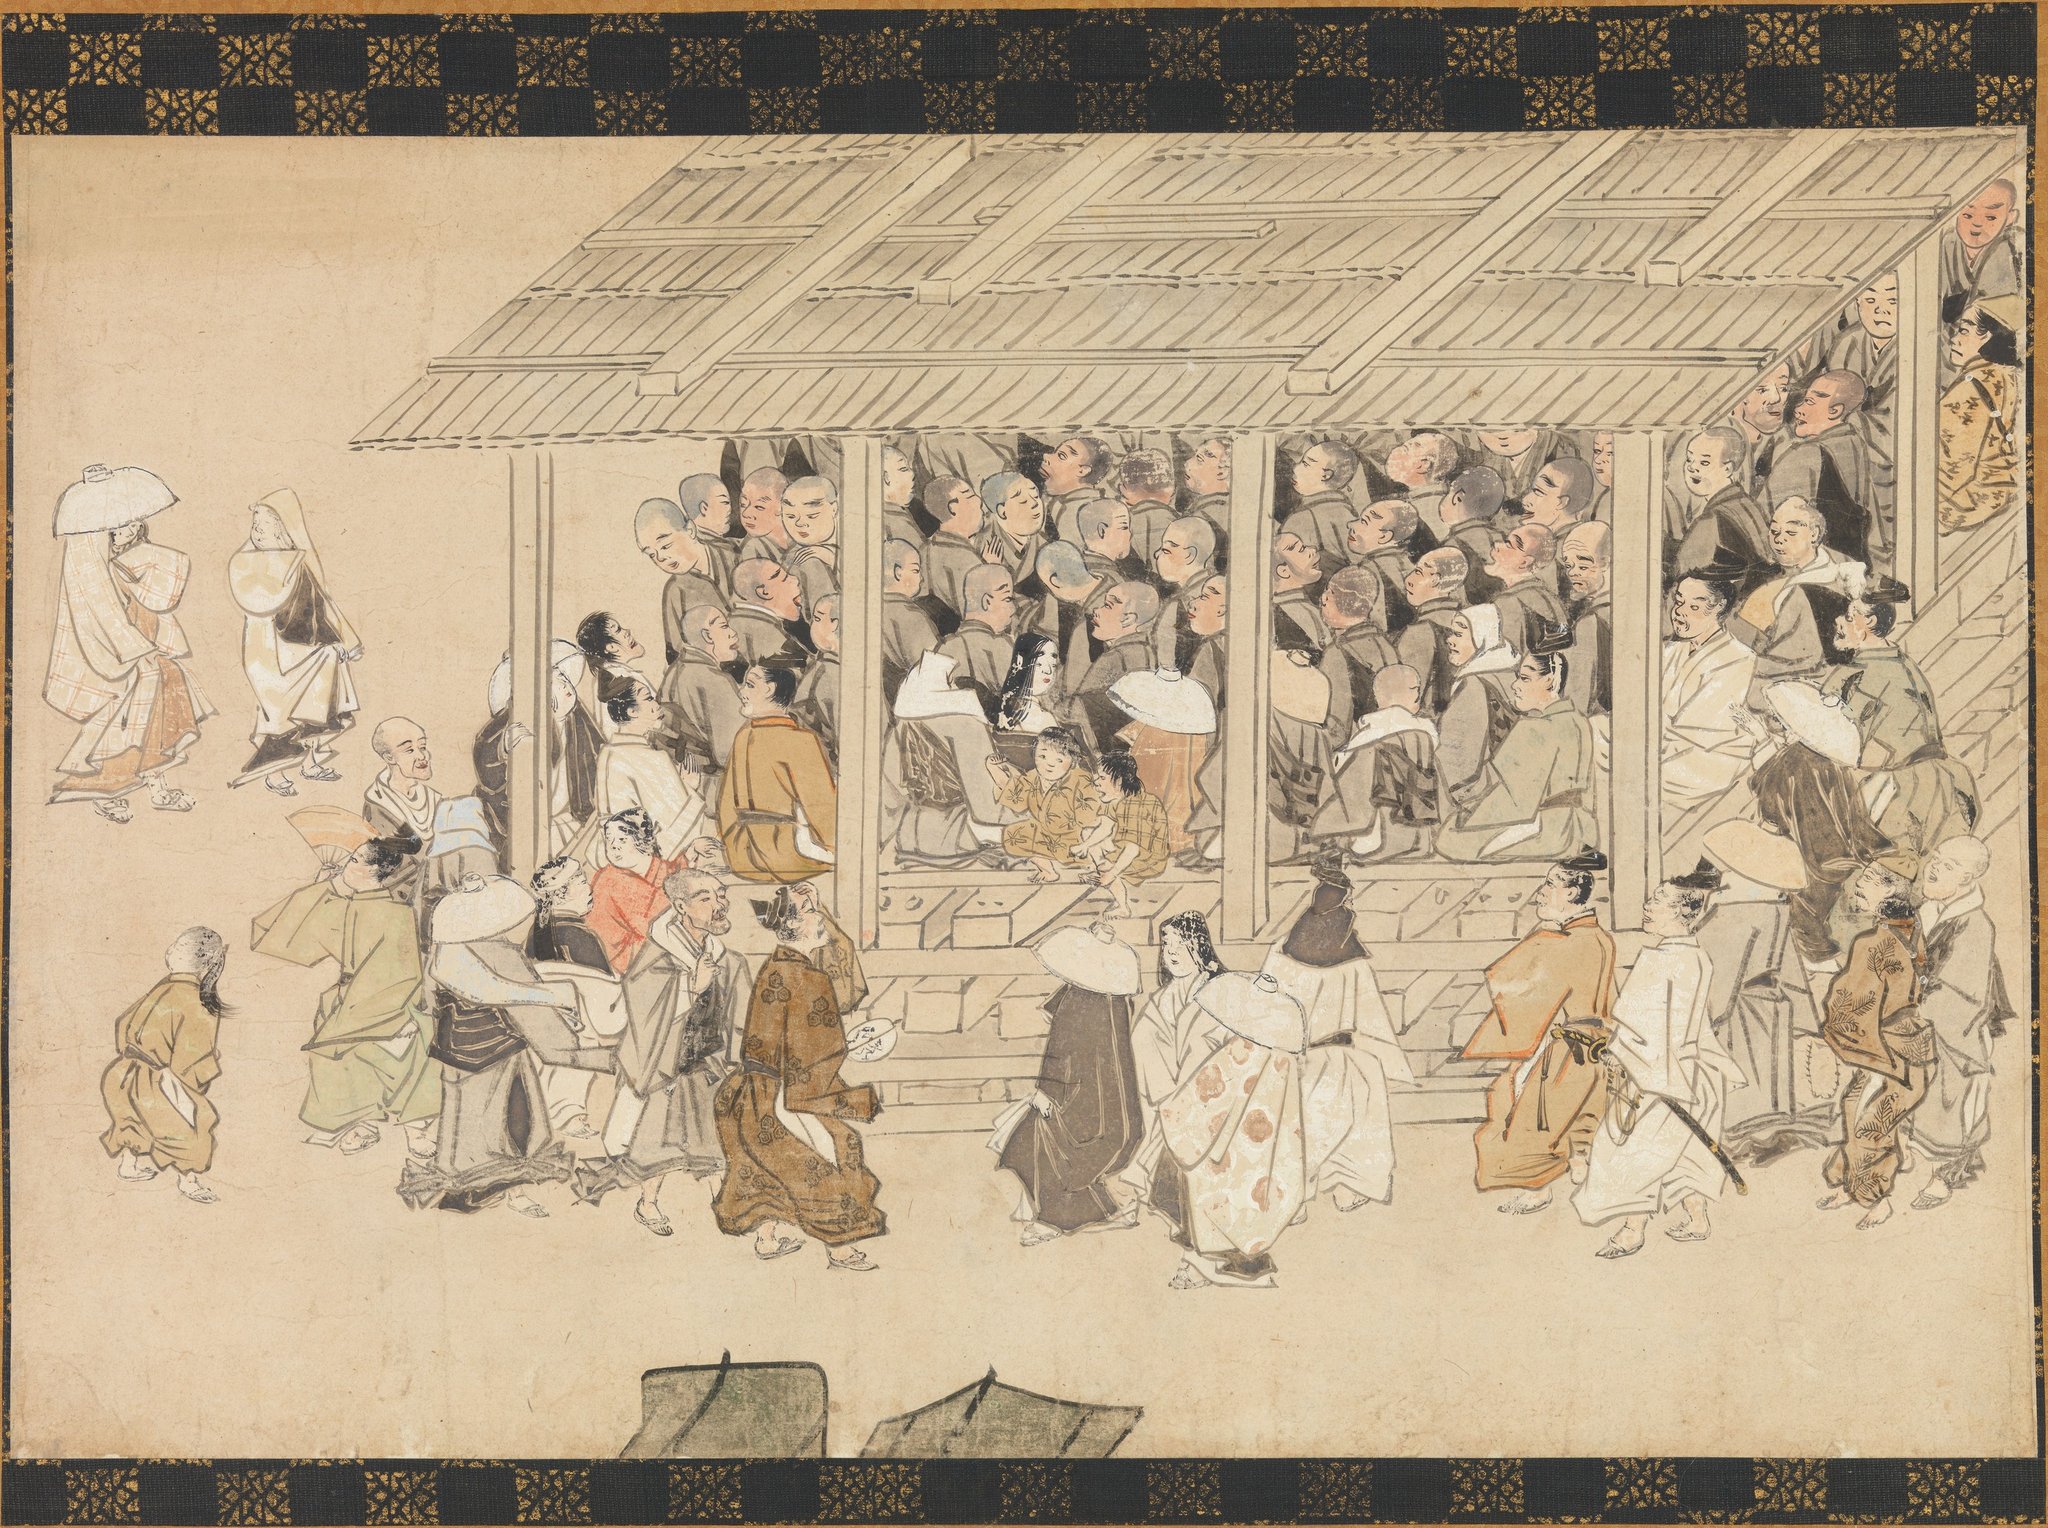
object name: hanging scroll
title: A Nenbutsu Gathering at Ichiya, Kyoto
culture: japanese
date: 1367-1400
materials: ink, paper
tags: men,women